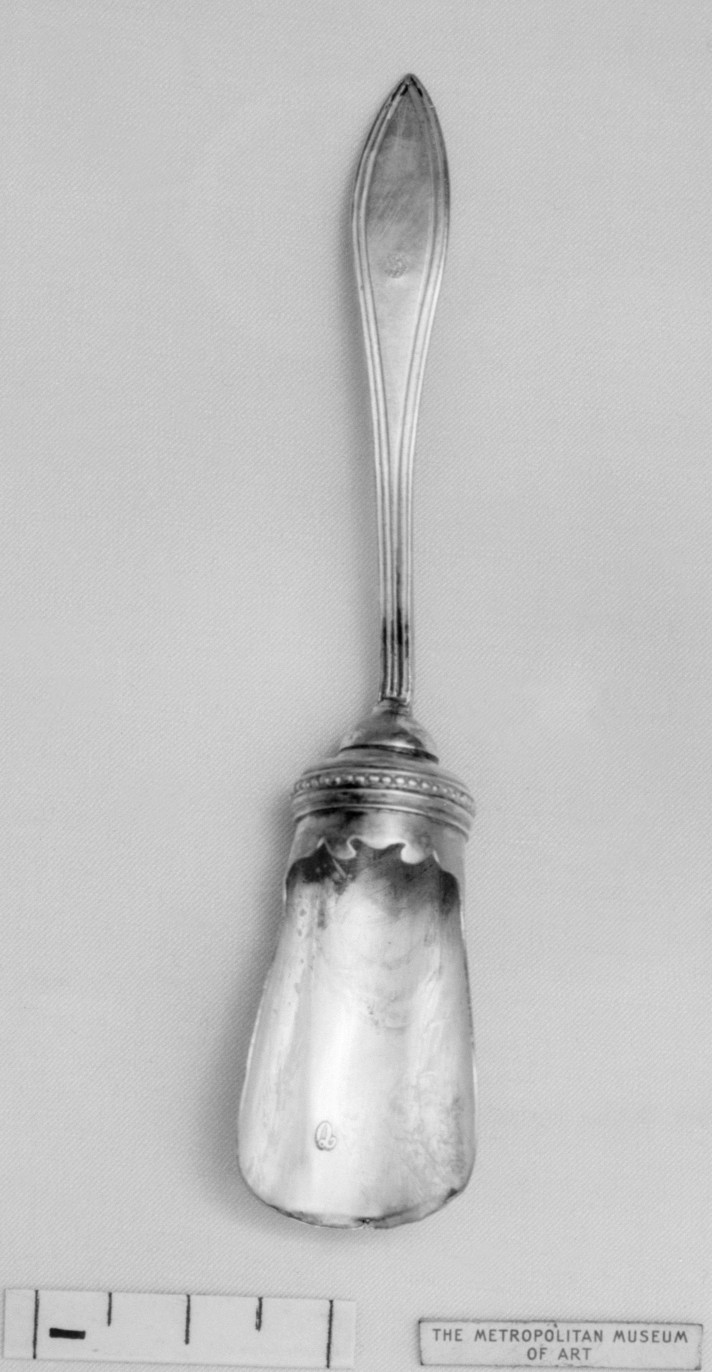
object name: caddy spoon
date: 1801-1833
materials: silver